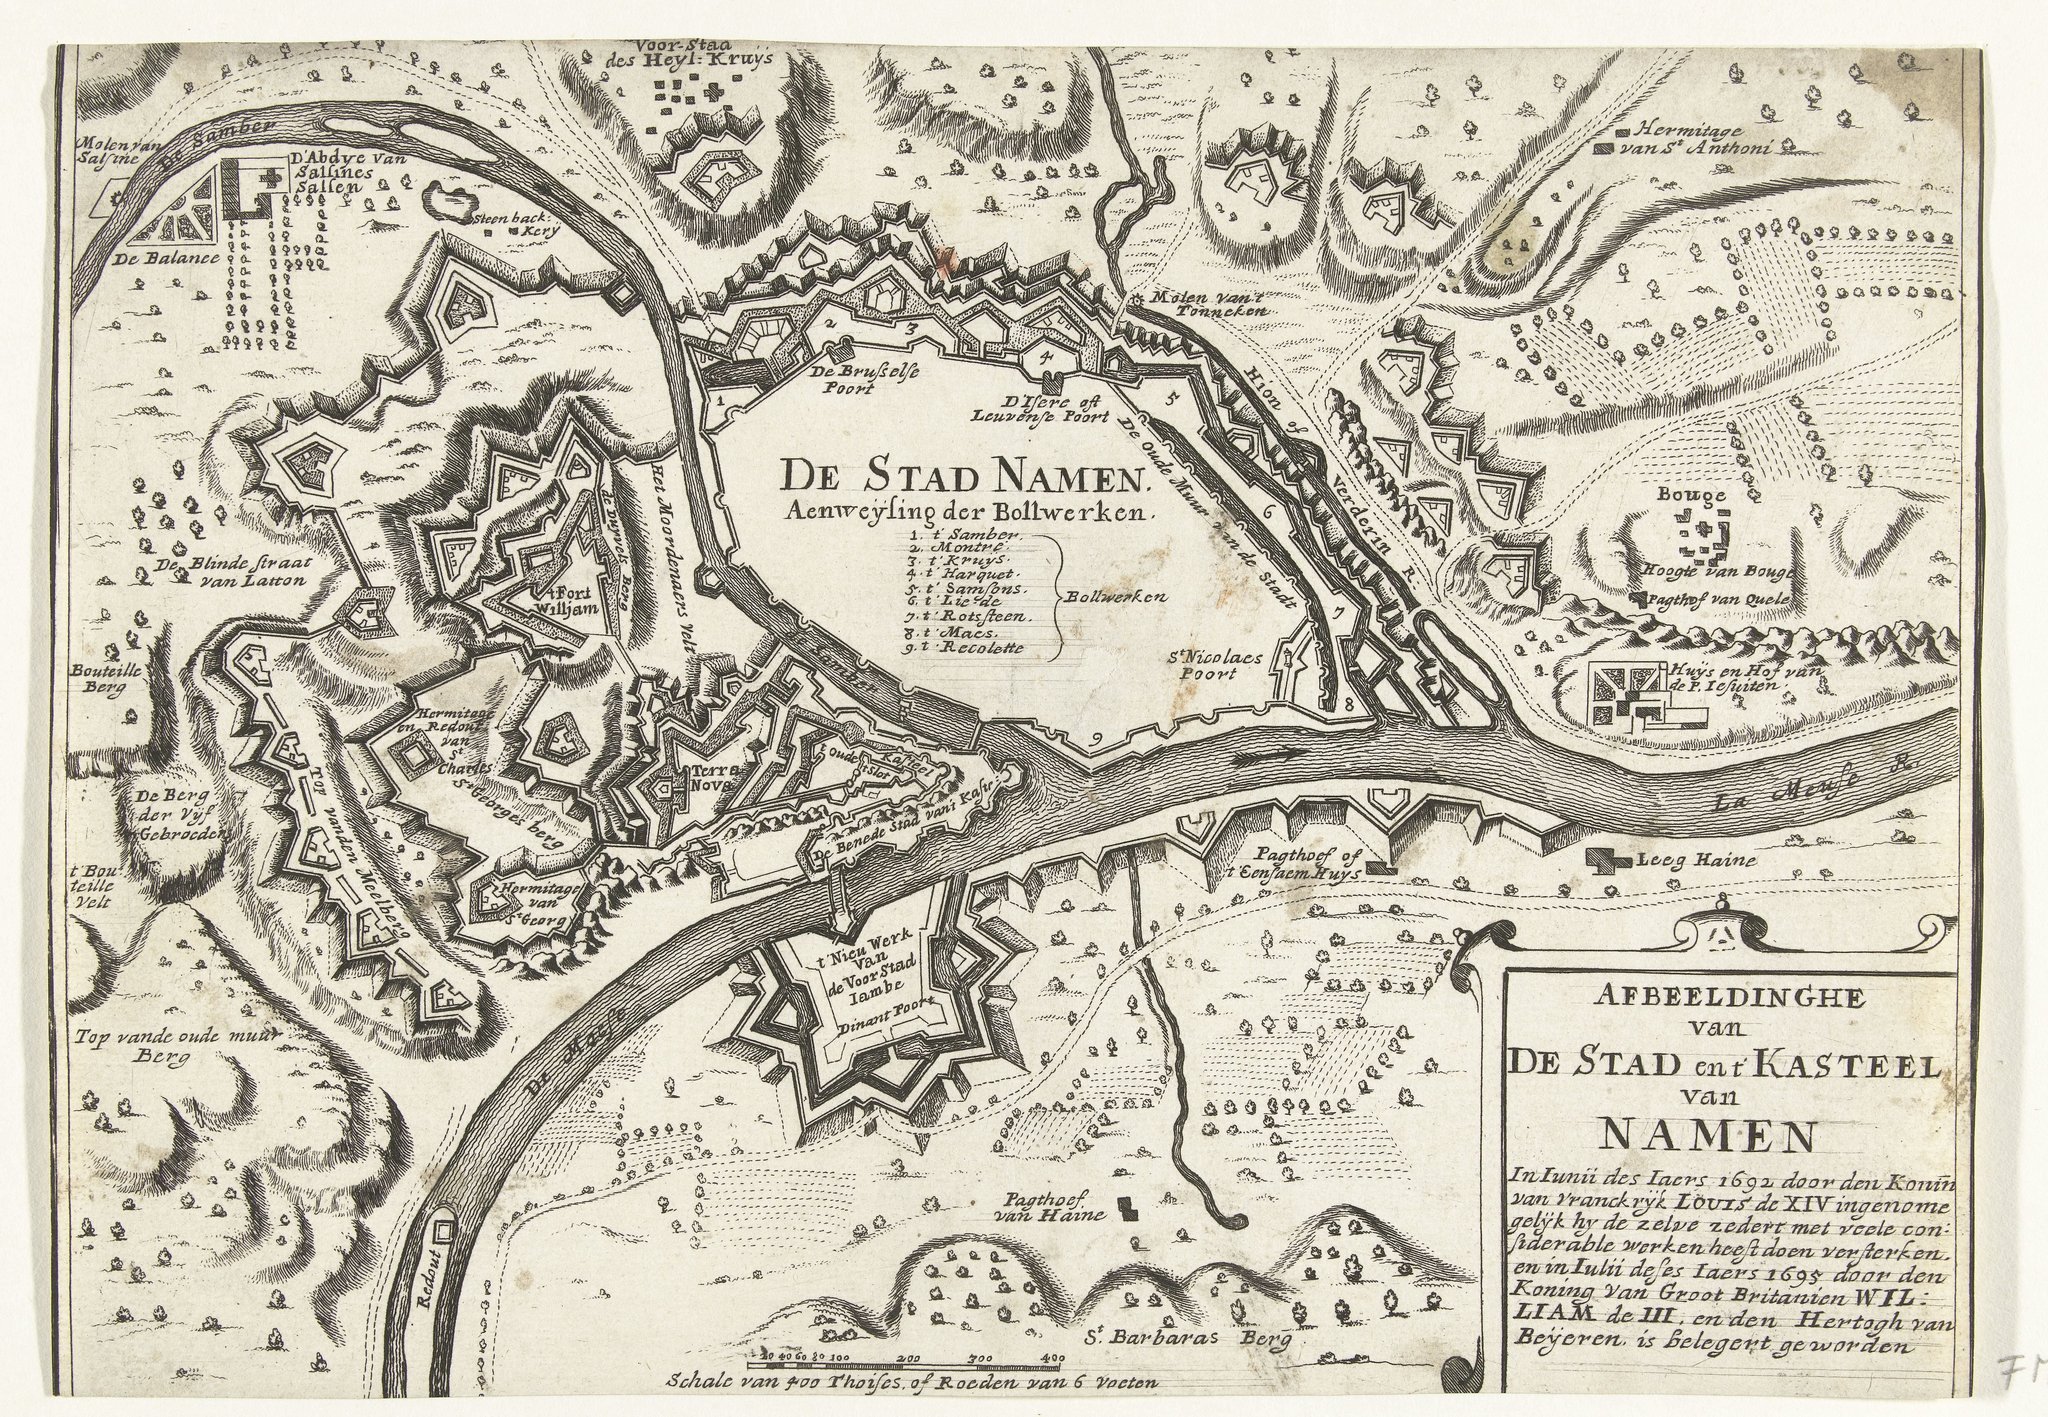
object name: map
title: Afbeeldinghe van de Stad en 't Kasteel van Namen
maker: Anonymous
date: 1695-1699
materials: paper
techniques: etching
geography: low countries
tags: maps of cities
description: Kaart van de stad Namen met kasteel, belegerd en ingenomen door het Franse leger in 1692 en heroverd door de geallieerden in 1695.